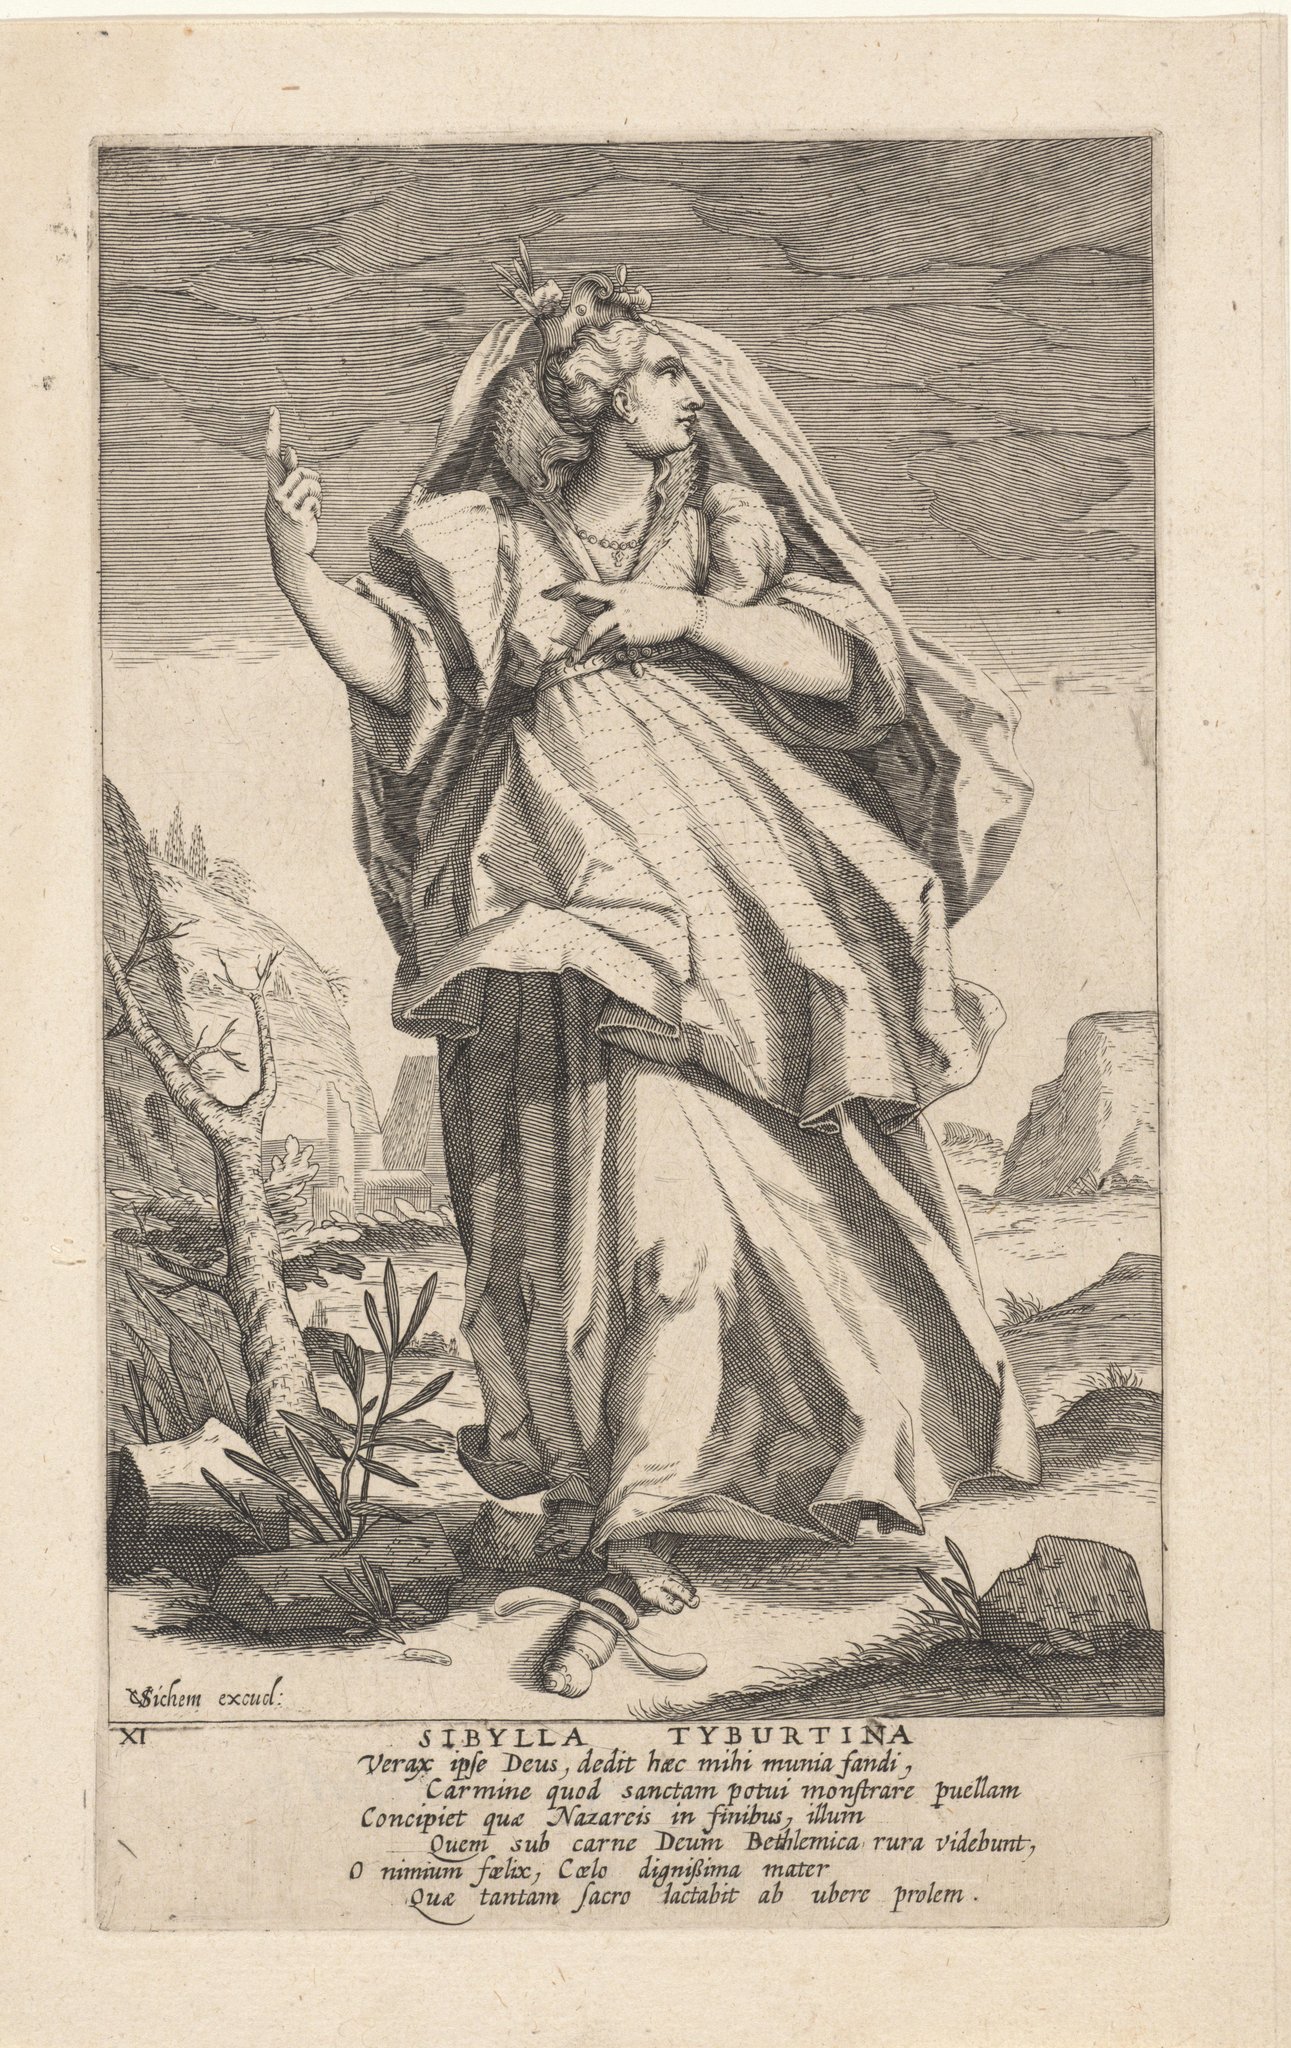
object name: print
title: Sibylla Tyburtina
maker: christoffel van sichem (i)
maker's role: print maker, publisher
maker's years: 1546-1624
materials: paper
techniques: engraving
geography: amsterdam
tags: sibyls (with name)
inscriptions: collector's mark: Lugt 2228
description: Prent tevens gebruikt in: (Onuphrius Panvinius). Beschryvinghe ende heerelĳcke afbeeldinghe der twaelf Sibyllen. Vertaald uit het Latijn door R. Lubbaeus. Amsterdam: C. van Sichem, 1608.